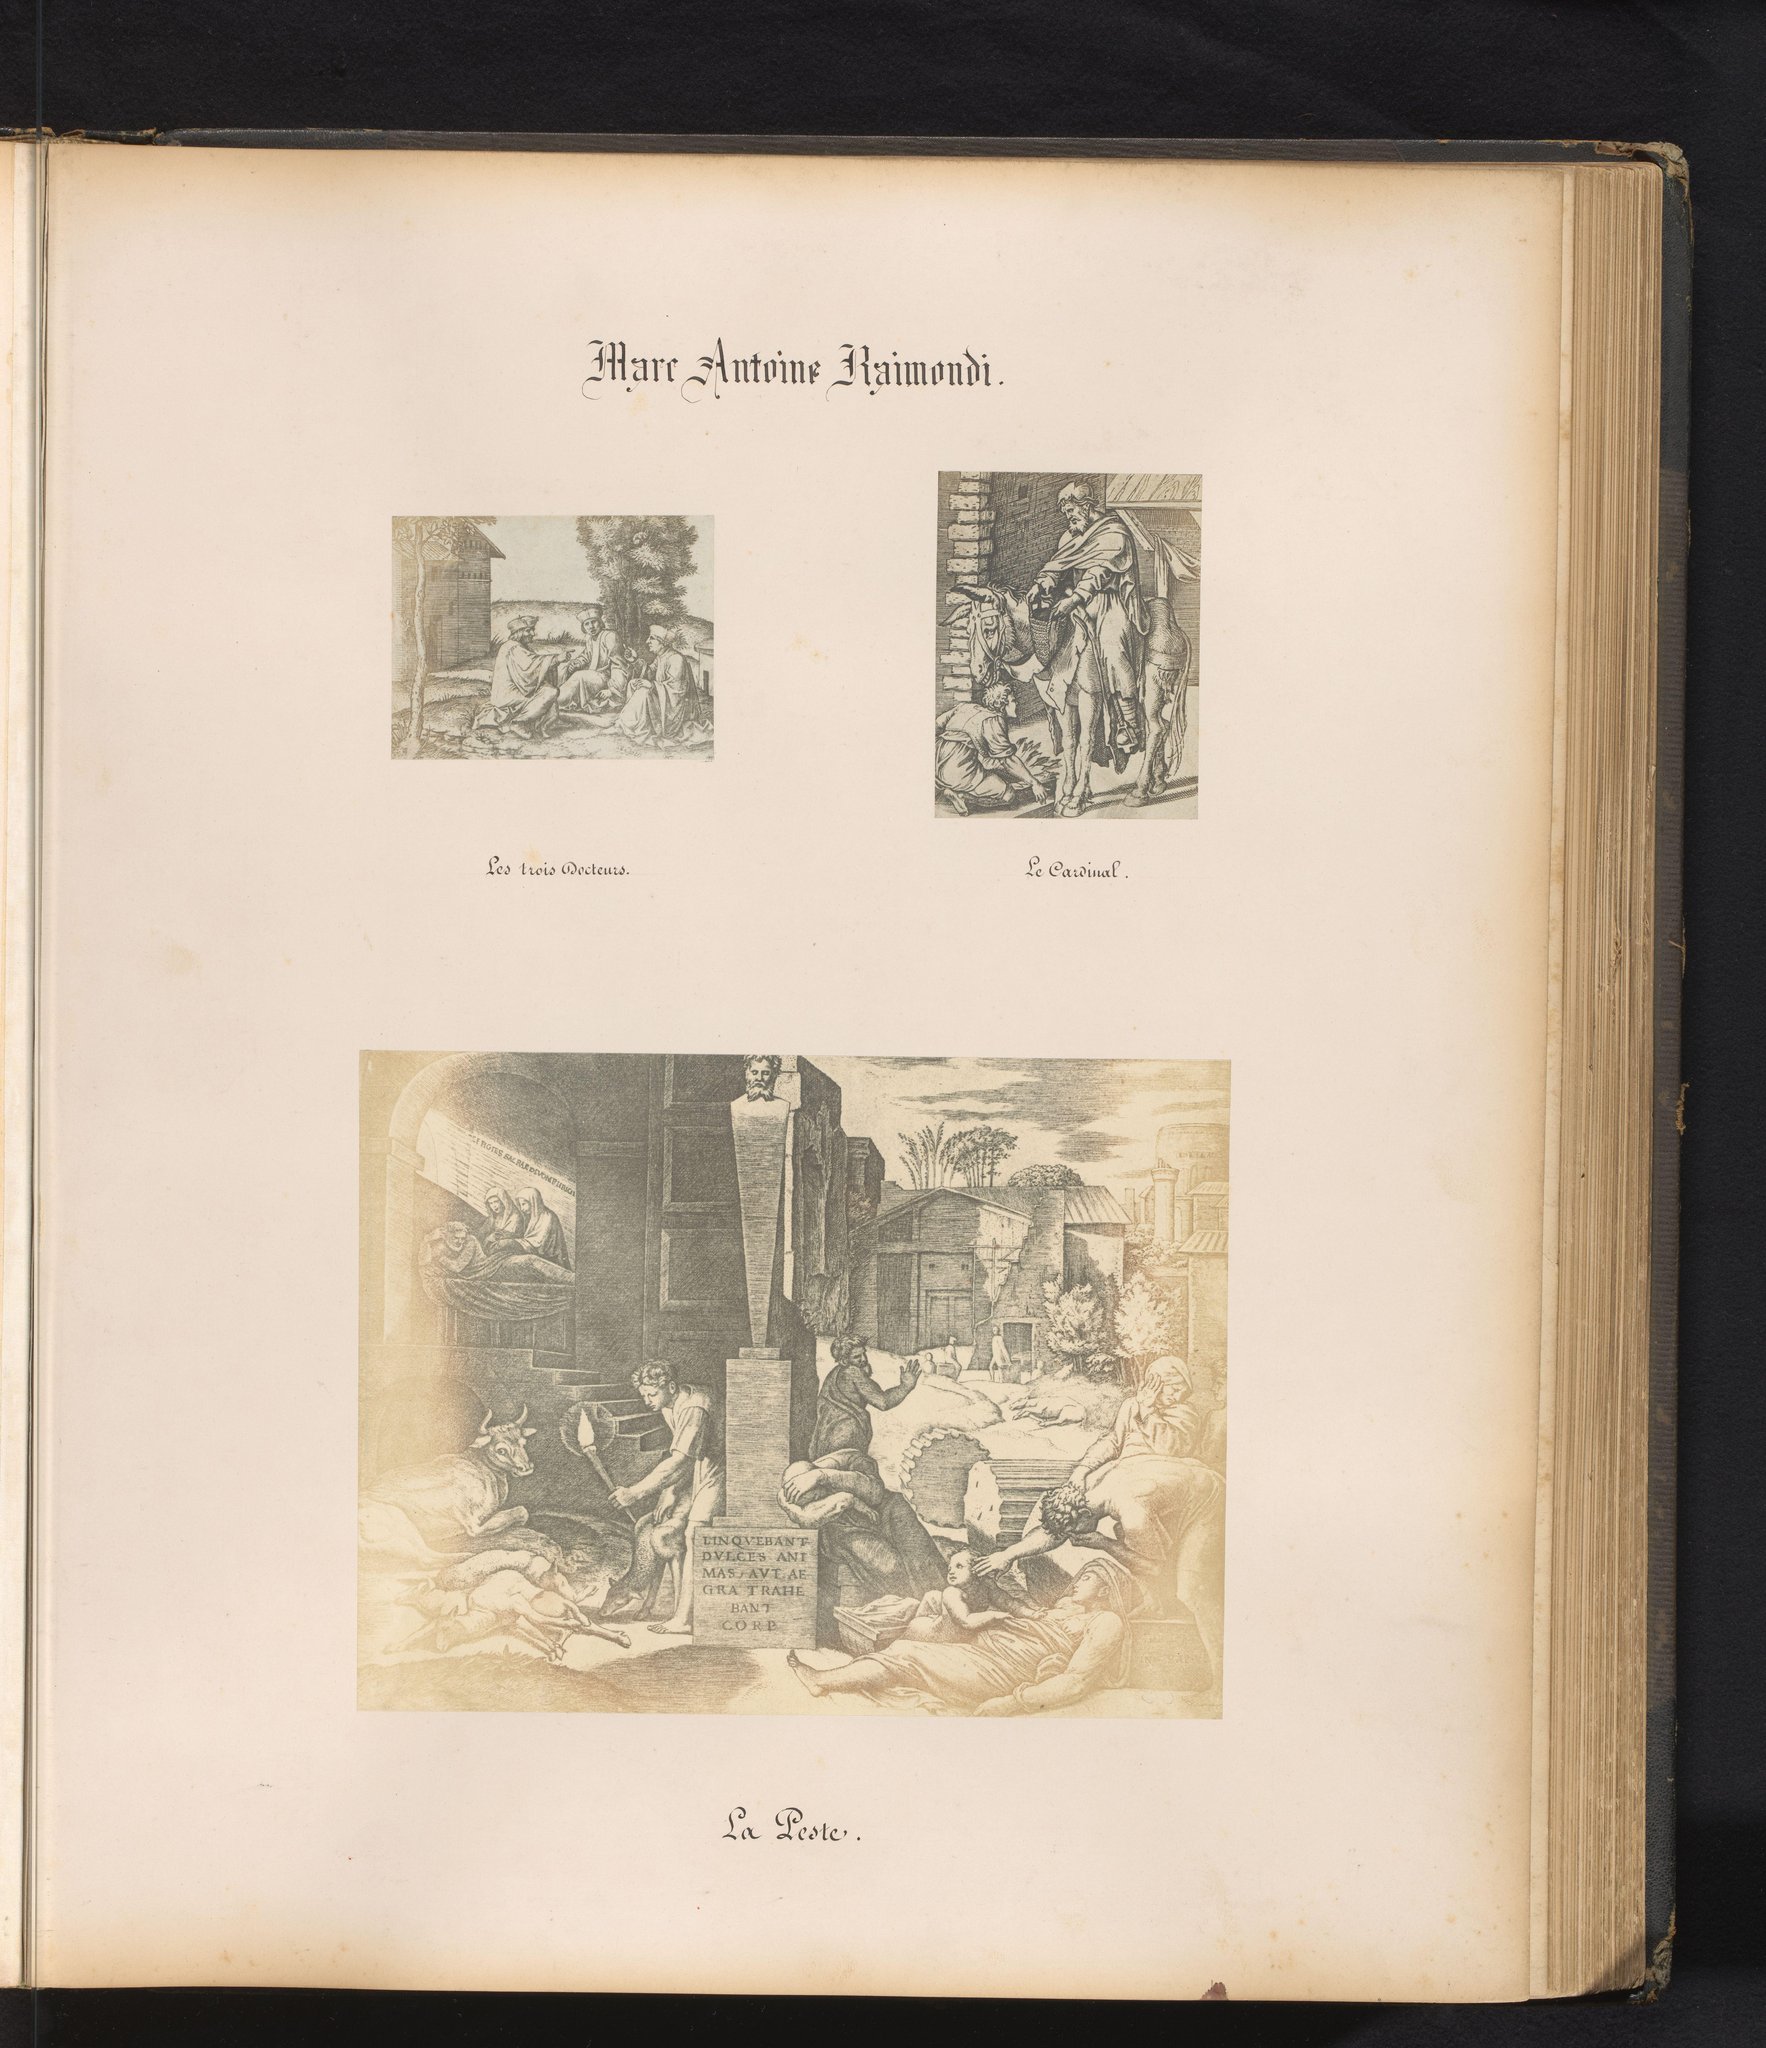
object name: page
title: Le Cardinal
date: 1848-1853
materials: photographic support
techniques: salted paper print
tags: cardinal